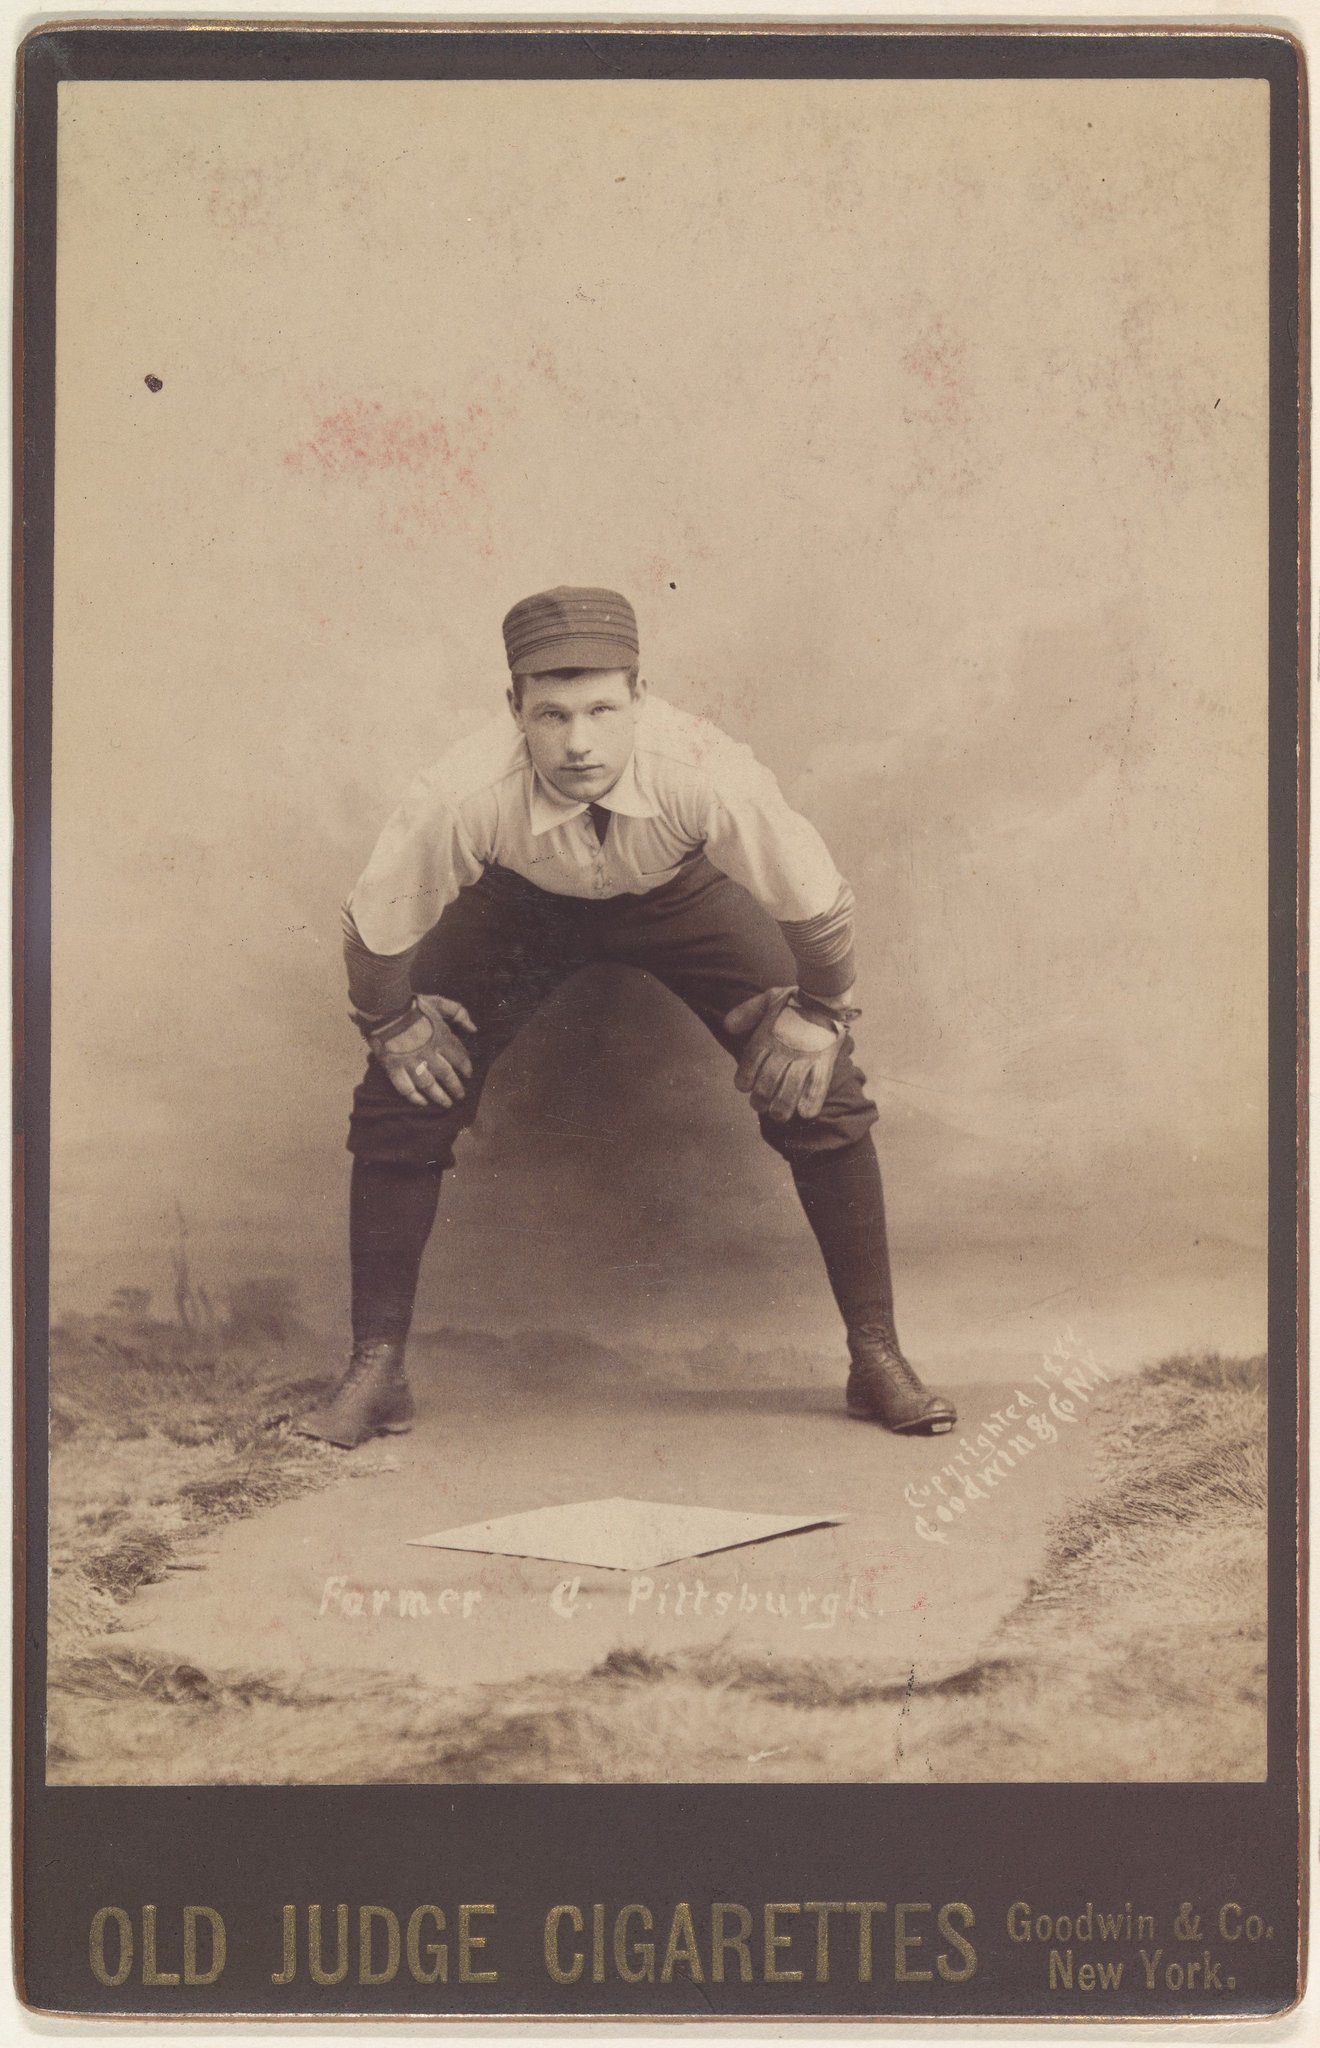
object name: baseball card, photograph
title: William Charles Farmer, Catcher, Pittsburgh, from the series Old Judge Cigarettes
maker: goodwin & company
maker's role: publisher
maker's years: 1850-1950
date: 1888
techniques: albumen print, photography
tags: men,portraits,baseball,athletes